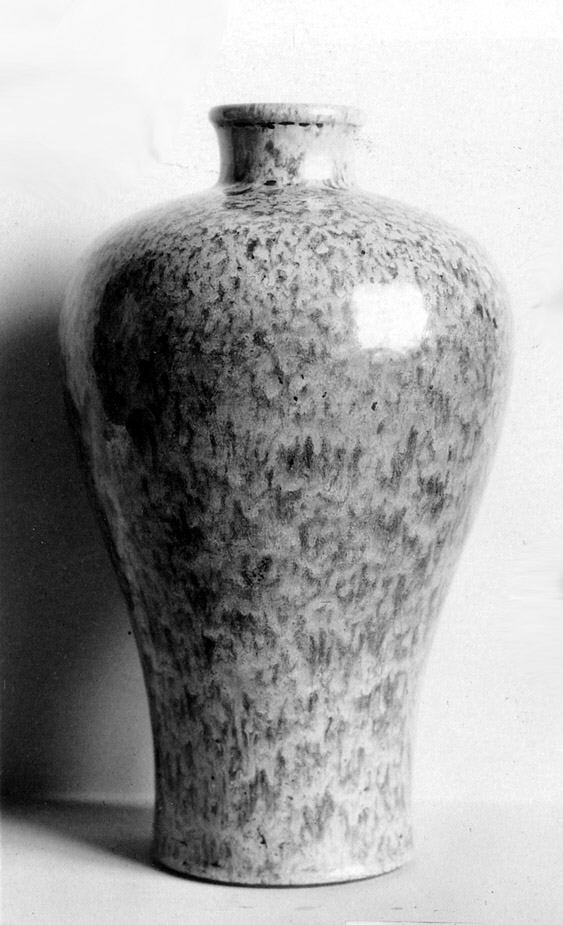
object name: vase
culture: chinese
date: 1701-1800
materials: glaze, porcelain